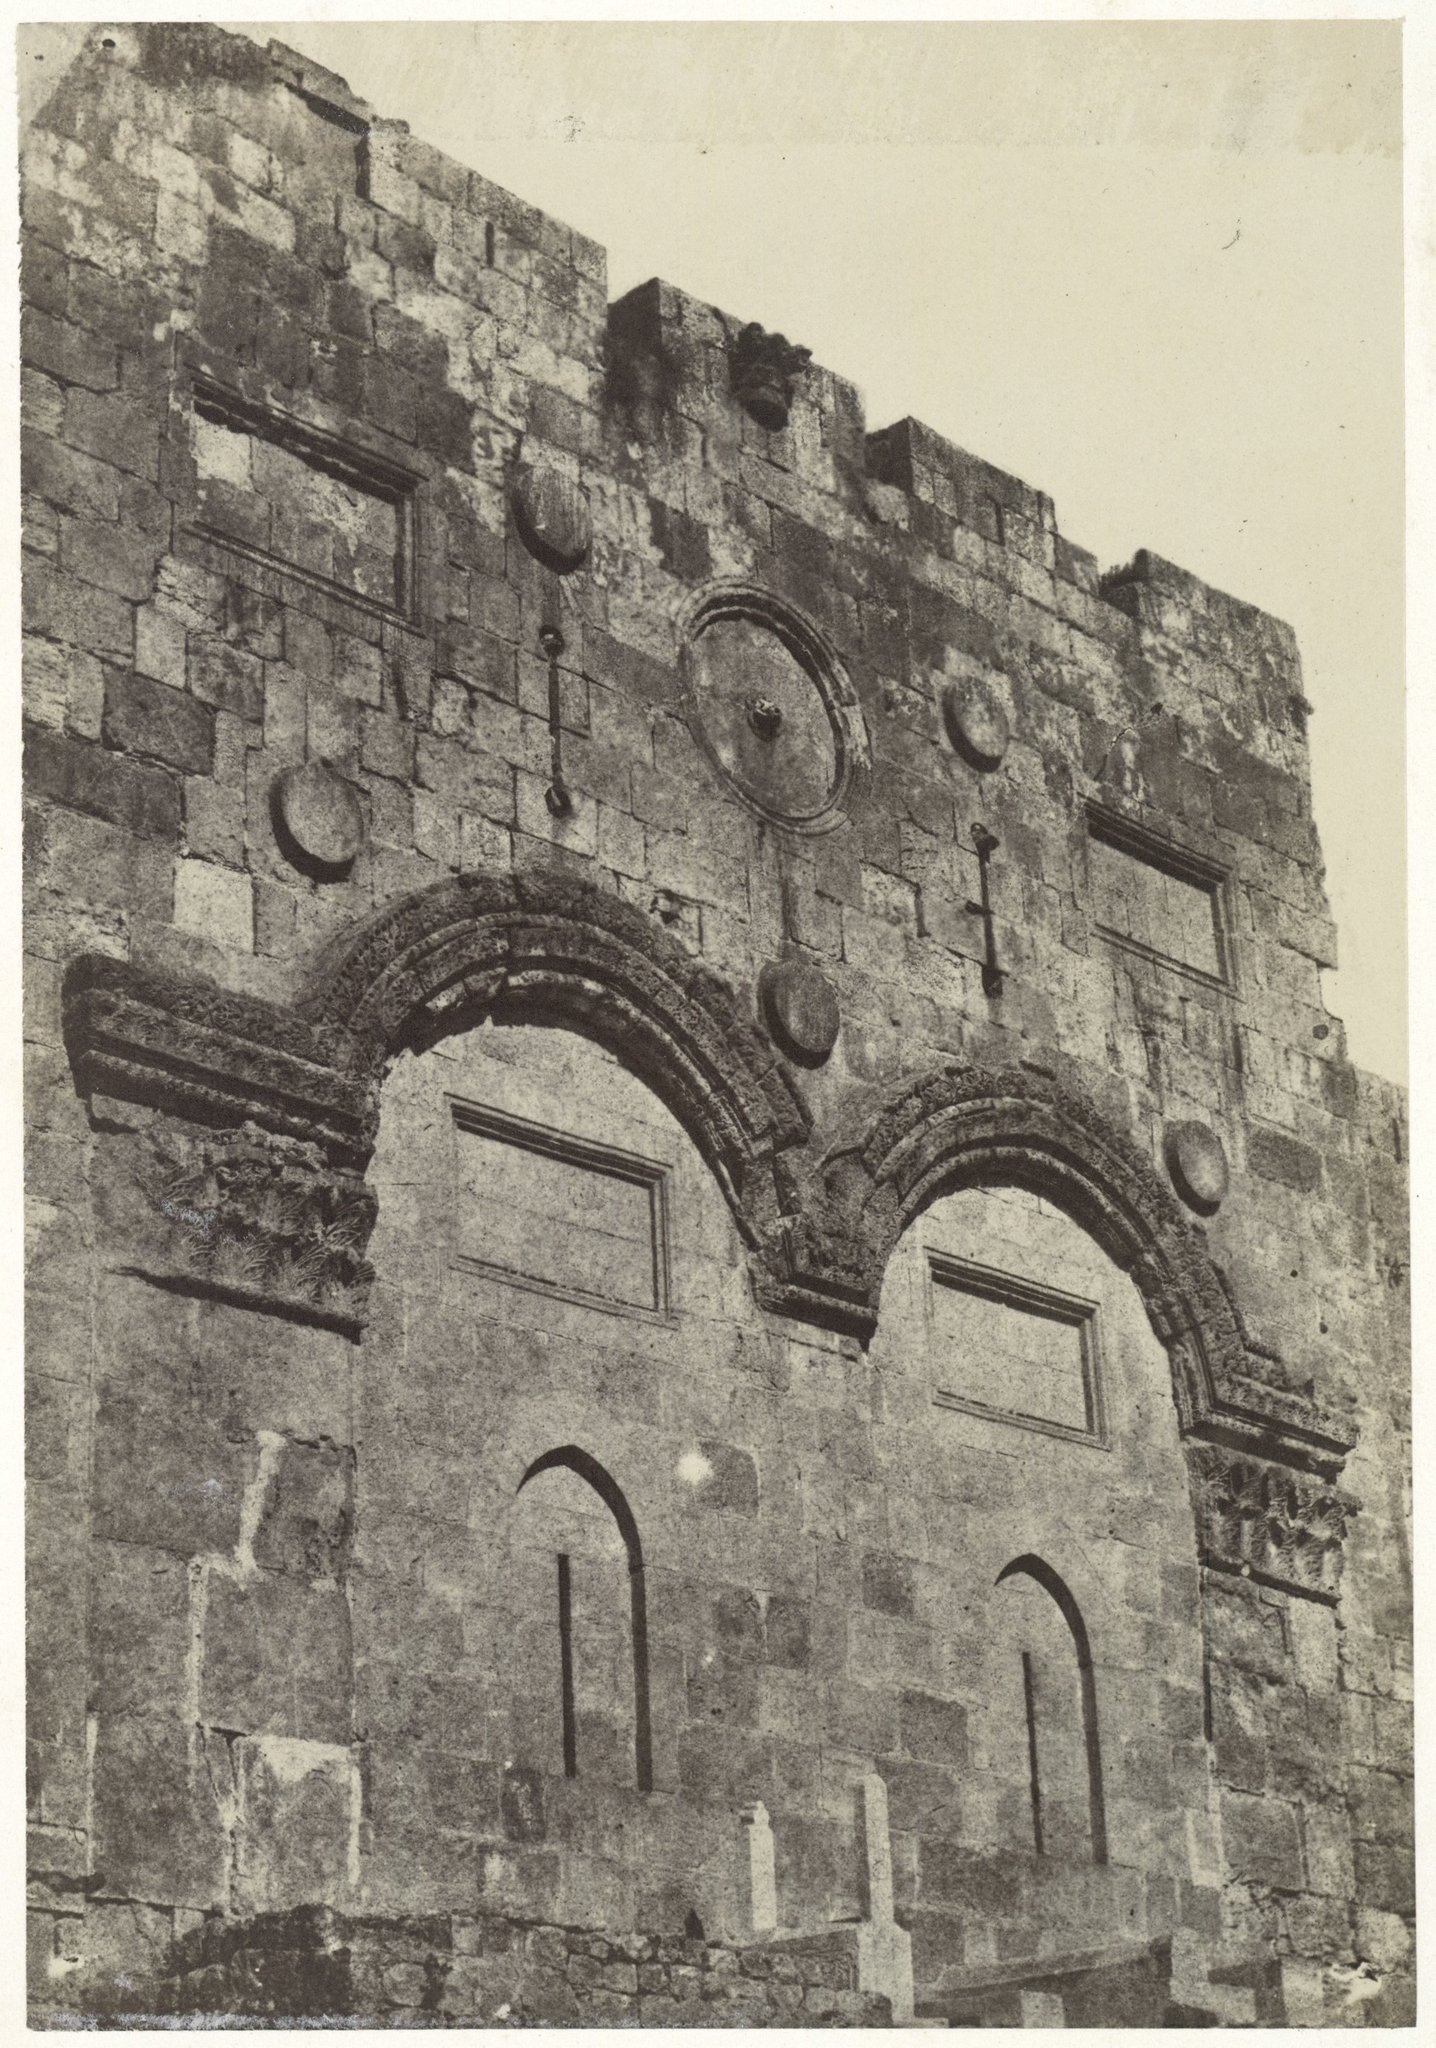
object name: photograph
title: Palestine Jérusalem porte Dorée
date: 1849-1851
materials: cardboard, paper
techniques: salted paper print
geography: jerusalem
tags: city-gate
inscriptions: caption: ‘Maxime Du Camp./ Gide et Baudry, Editeurs./ JÉRUSALEM./ PORTE DORÉE./ Imprimerie Photographique de Blanquard-Evrard, à Lille./ Pl. 118.’